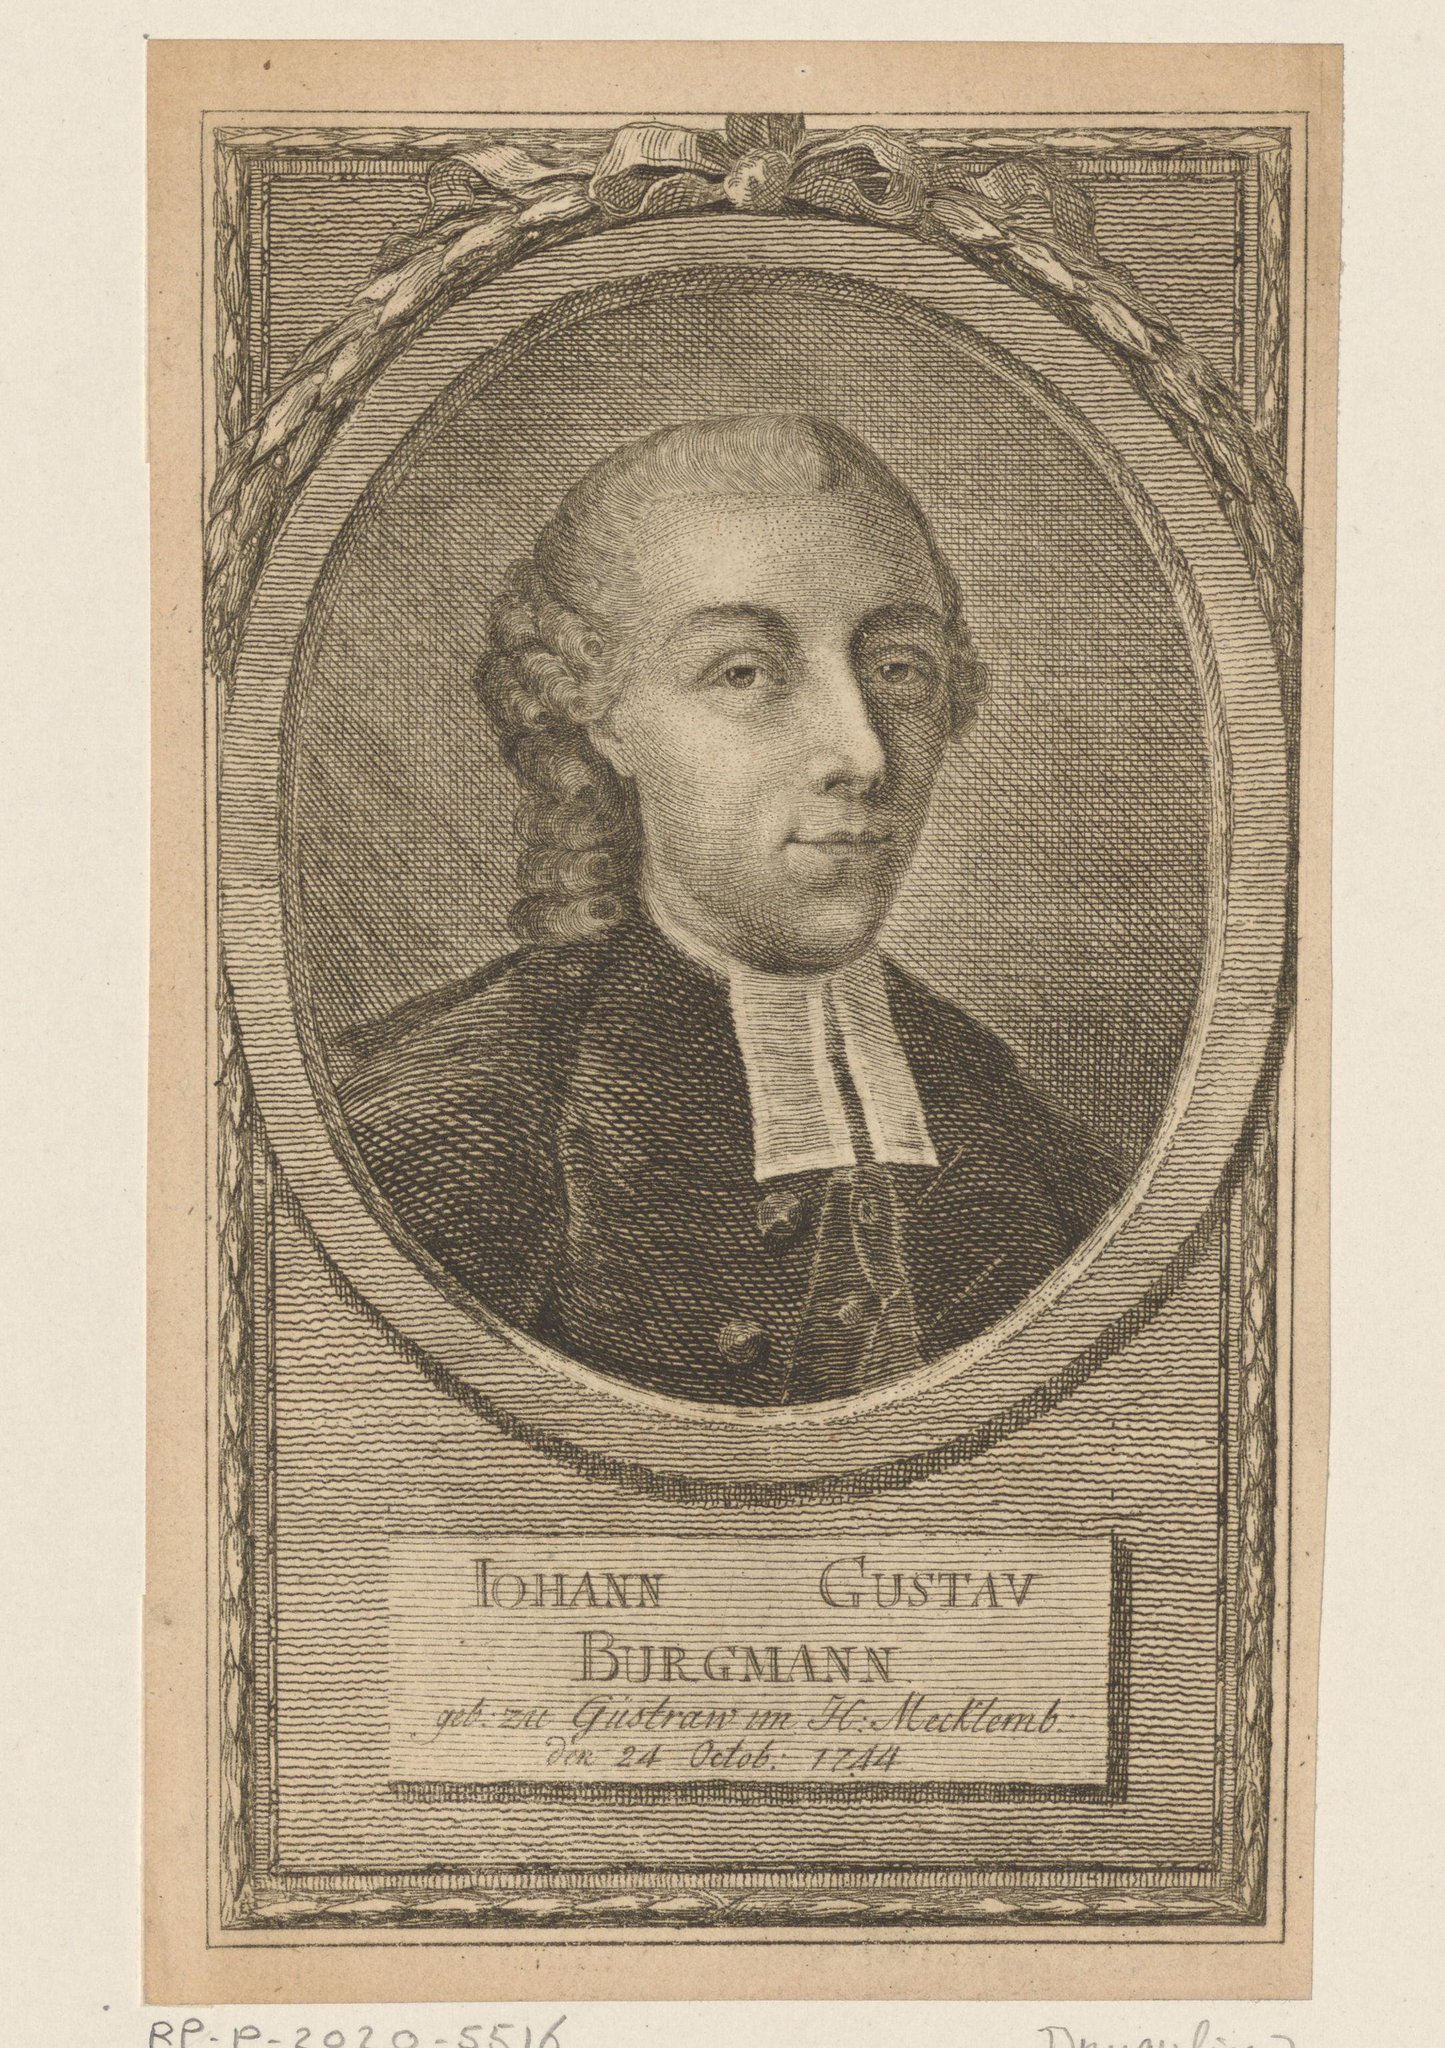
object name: print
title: Portret van Johann Gustav Burgmann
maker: Anonymous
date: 1775-1799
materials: paper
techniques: engraving, etching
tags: theologian, historical persons